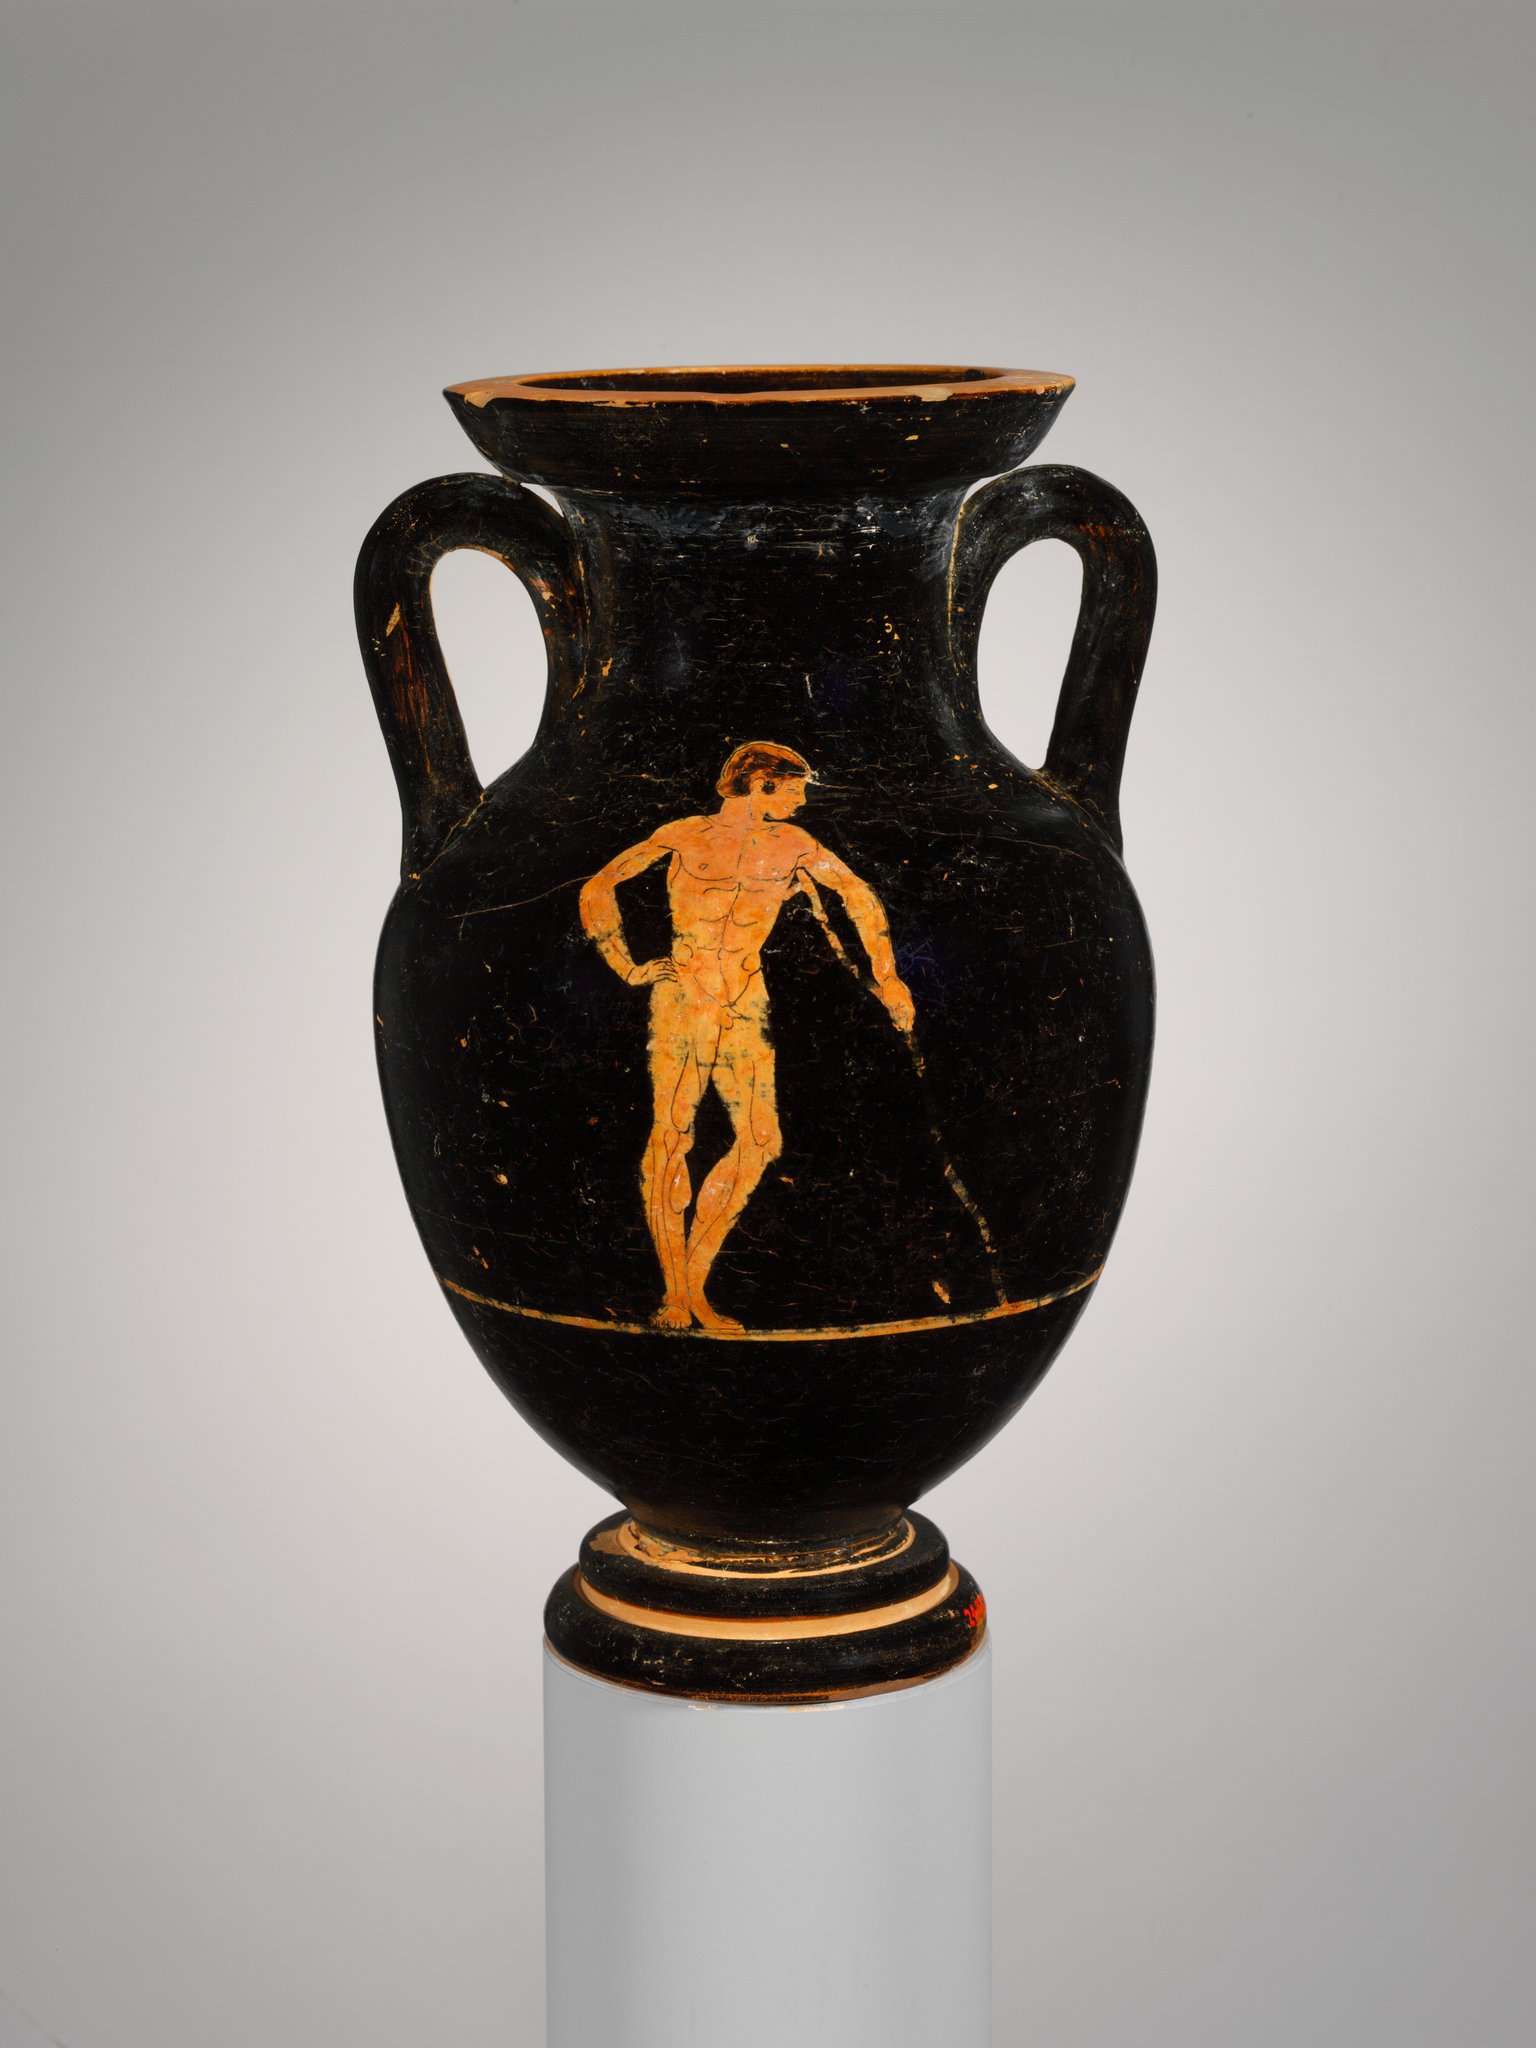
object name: amphora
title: Terracotta amphora (jar)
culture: etruscan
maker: praxias group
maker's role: artist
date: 500-468 BCE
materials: terracotta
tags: male nudes